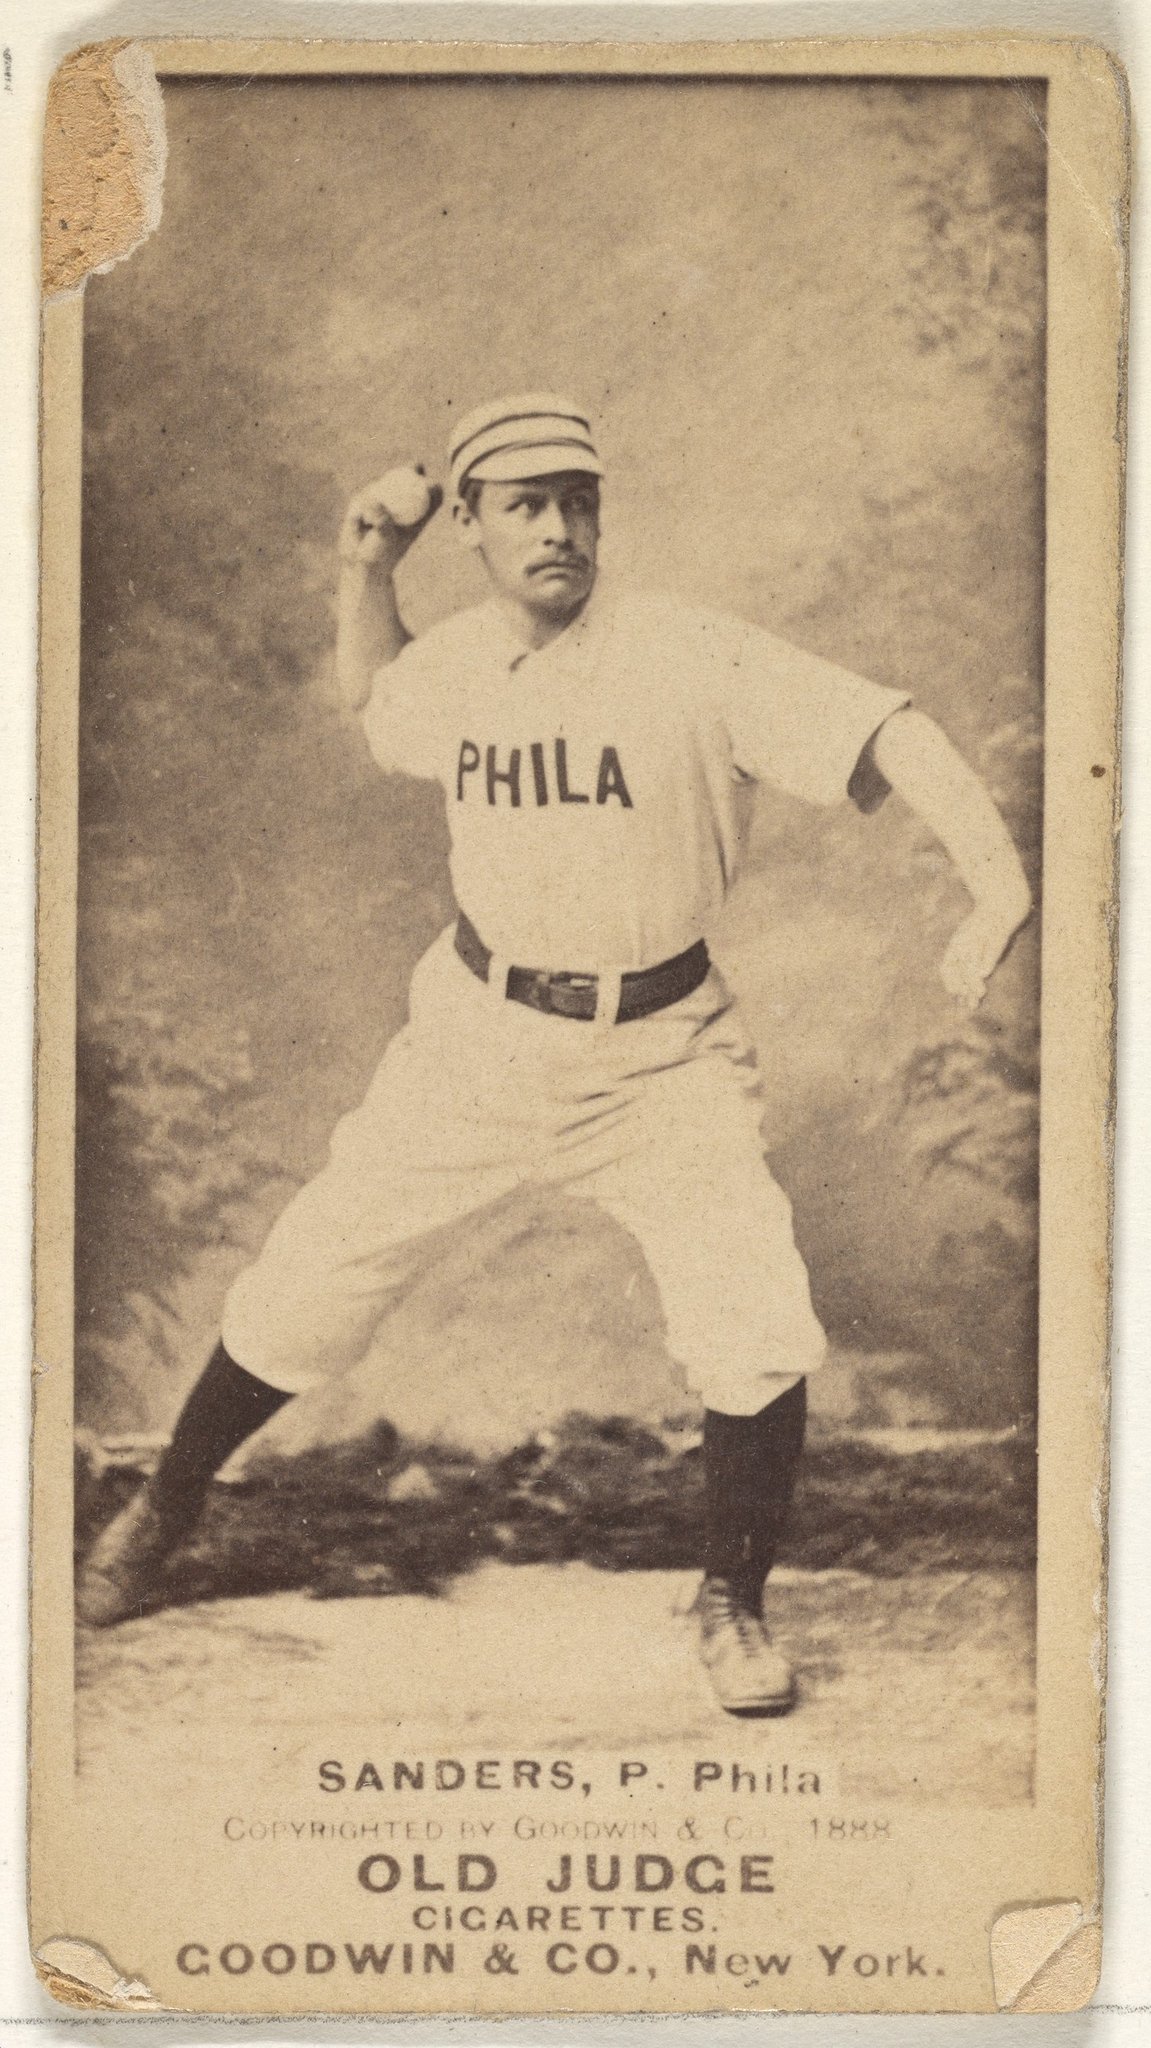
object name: baseball card, photograph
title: Alexander Bennett "Ben" Sanders, Pitcher, Philadelphia, from the Old Judge series (N172) for Old Judge Cigarettes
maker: goodwin & company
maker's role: publisher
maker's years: 1850-1950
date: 1888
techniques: albumen silver print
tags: men,portraits,baseball,athletes